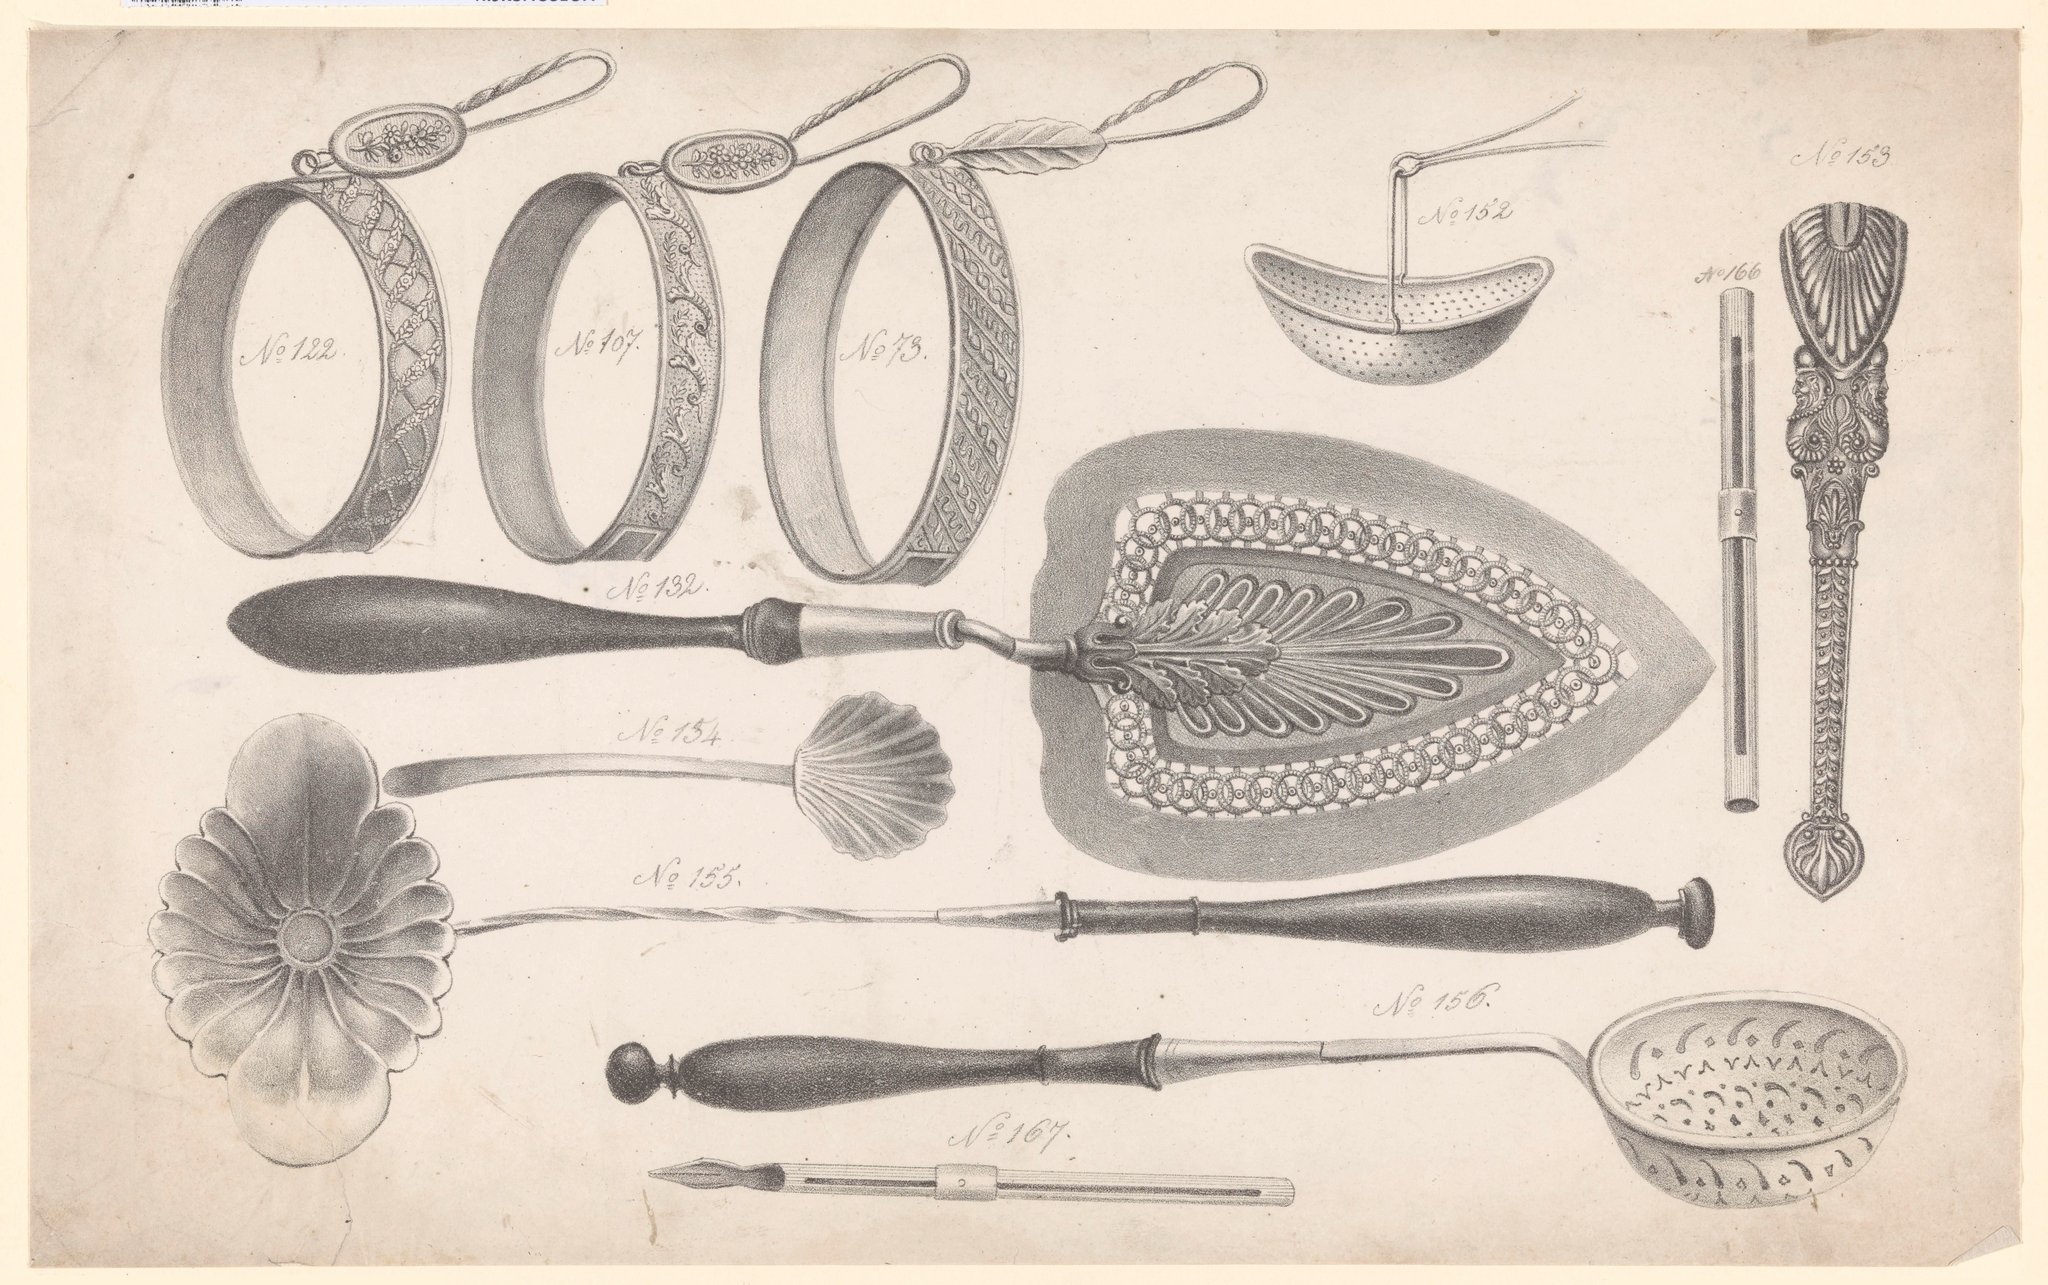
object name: ornament print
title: Ringen en bestek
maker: Anonymous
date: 1820-1840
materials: paper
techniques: lithograph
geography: germany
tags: napkin-ring, table-ware, styles in the fine arts (+ later developments), kitchen-utensils: sieve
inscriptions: collector's mark: Lugt 2760, collector's mark: Lugt 2228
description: Waarschijnlijk onderdeel van een catalogus. Mogelijke prentmaker of drukker is Firma Leudesdorf-Mansfeld te Elberfeld. Zie RP-P-1965-504 en 505.